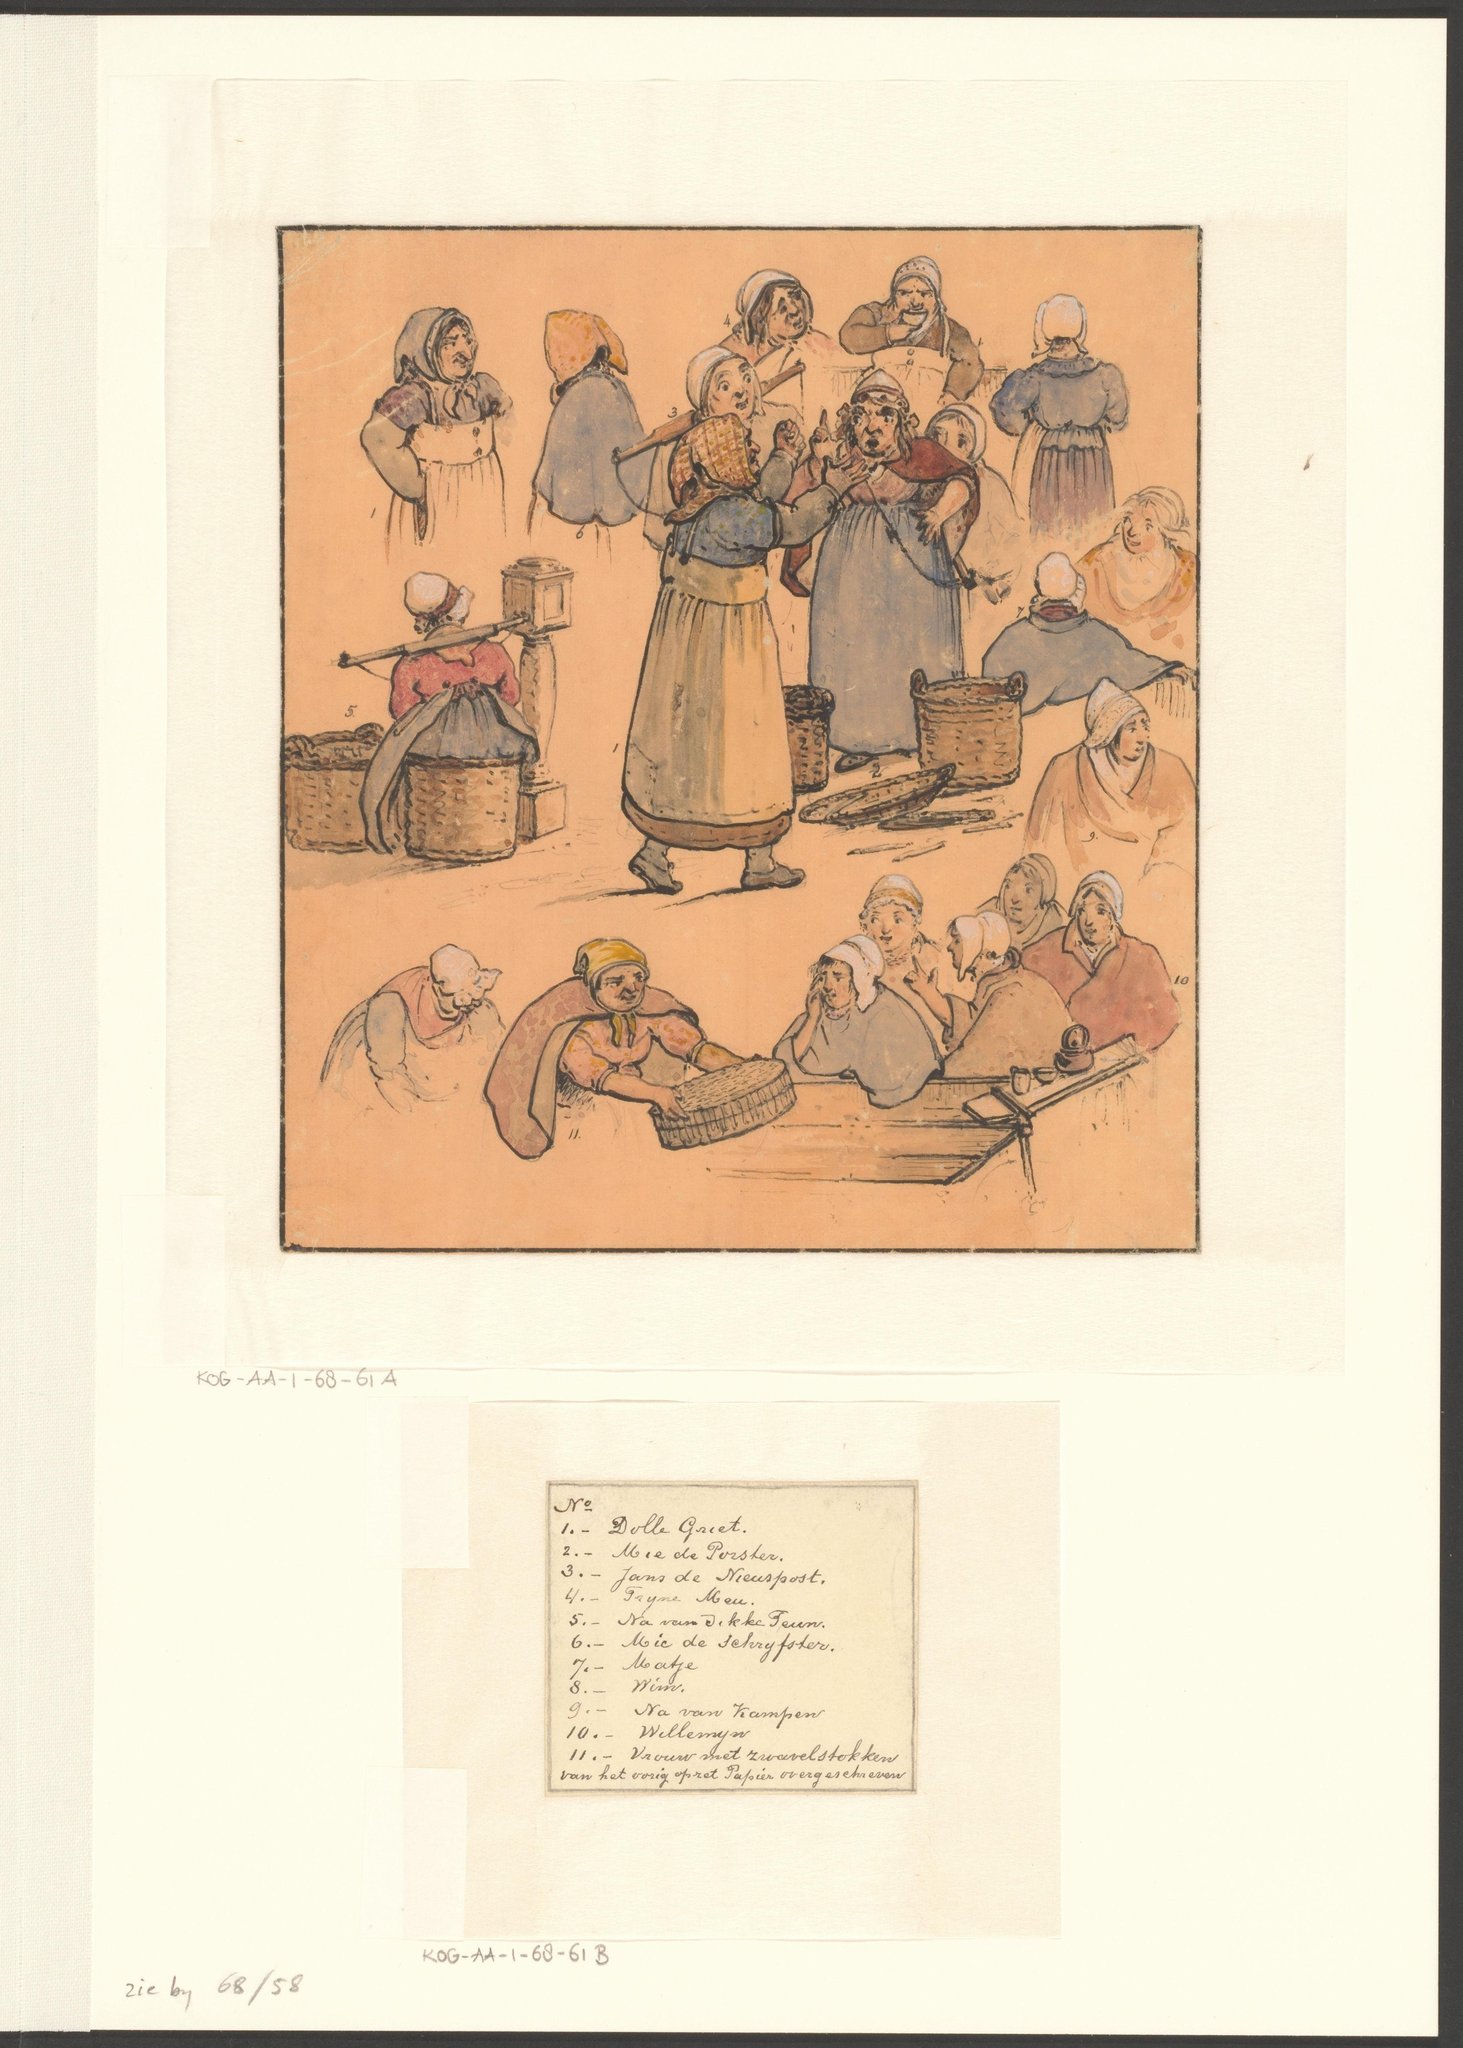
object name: text sheet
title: Legenda behorende bij compositie met Amsterdamse volksvrouwen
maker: christiaan andriessen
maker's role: draughtsman, print maker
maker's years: 1775-1846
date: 1785-1846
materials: ink, paper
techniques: pen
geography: amsterdam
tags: handwriting, written text, amsterdam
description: Onderwerpsrubriek binnen de Atlas Amsterdam: Amsterdamsche Typen AB - A.